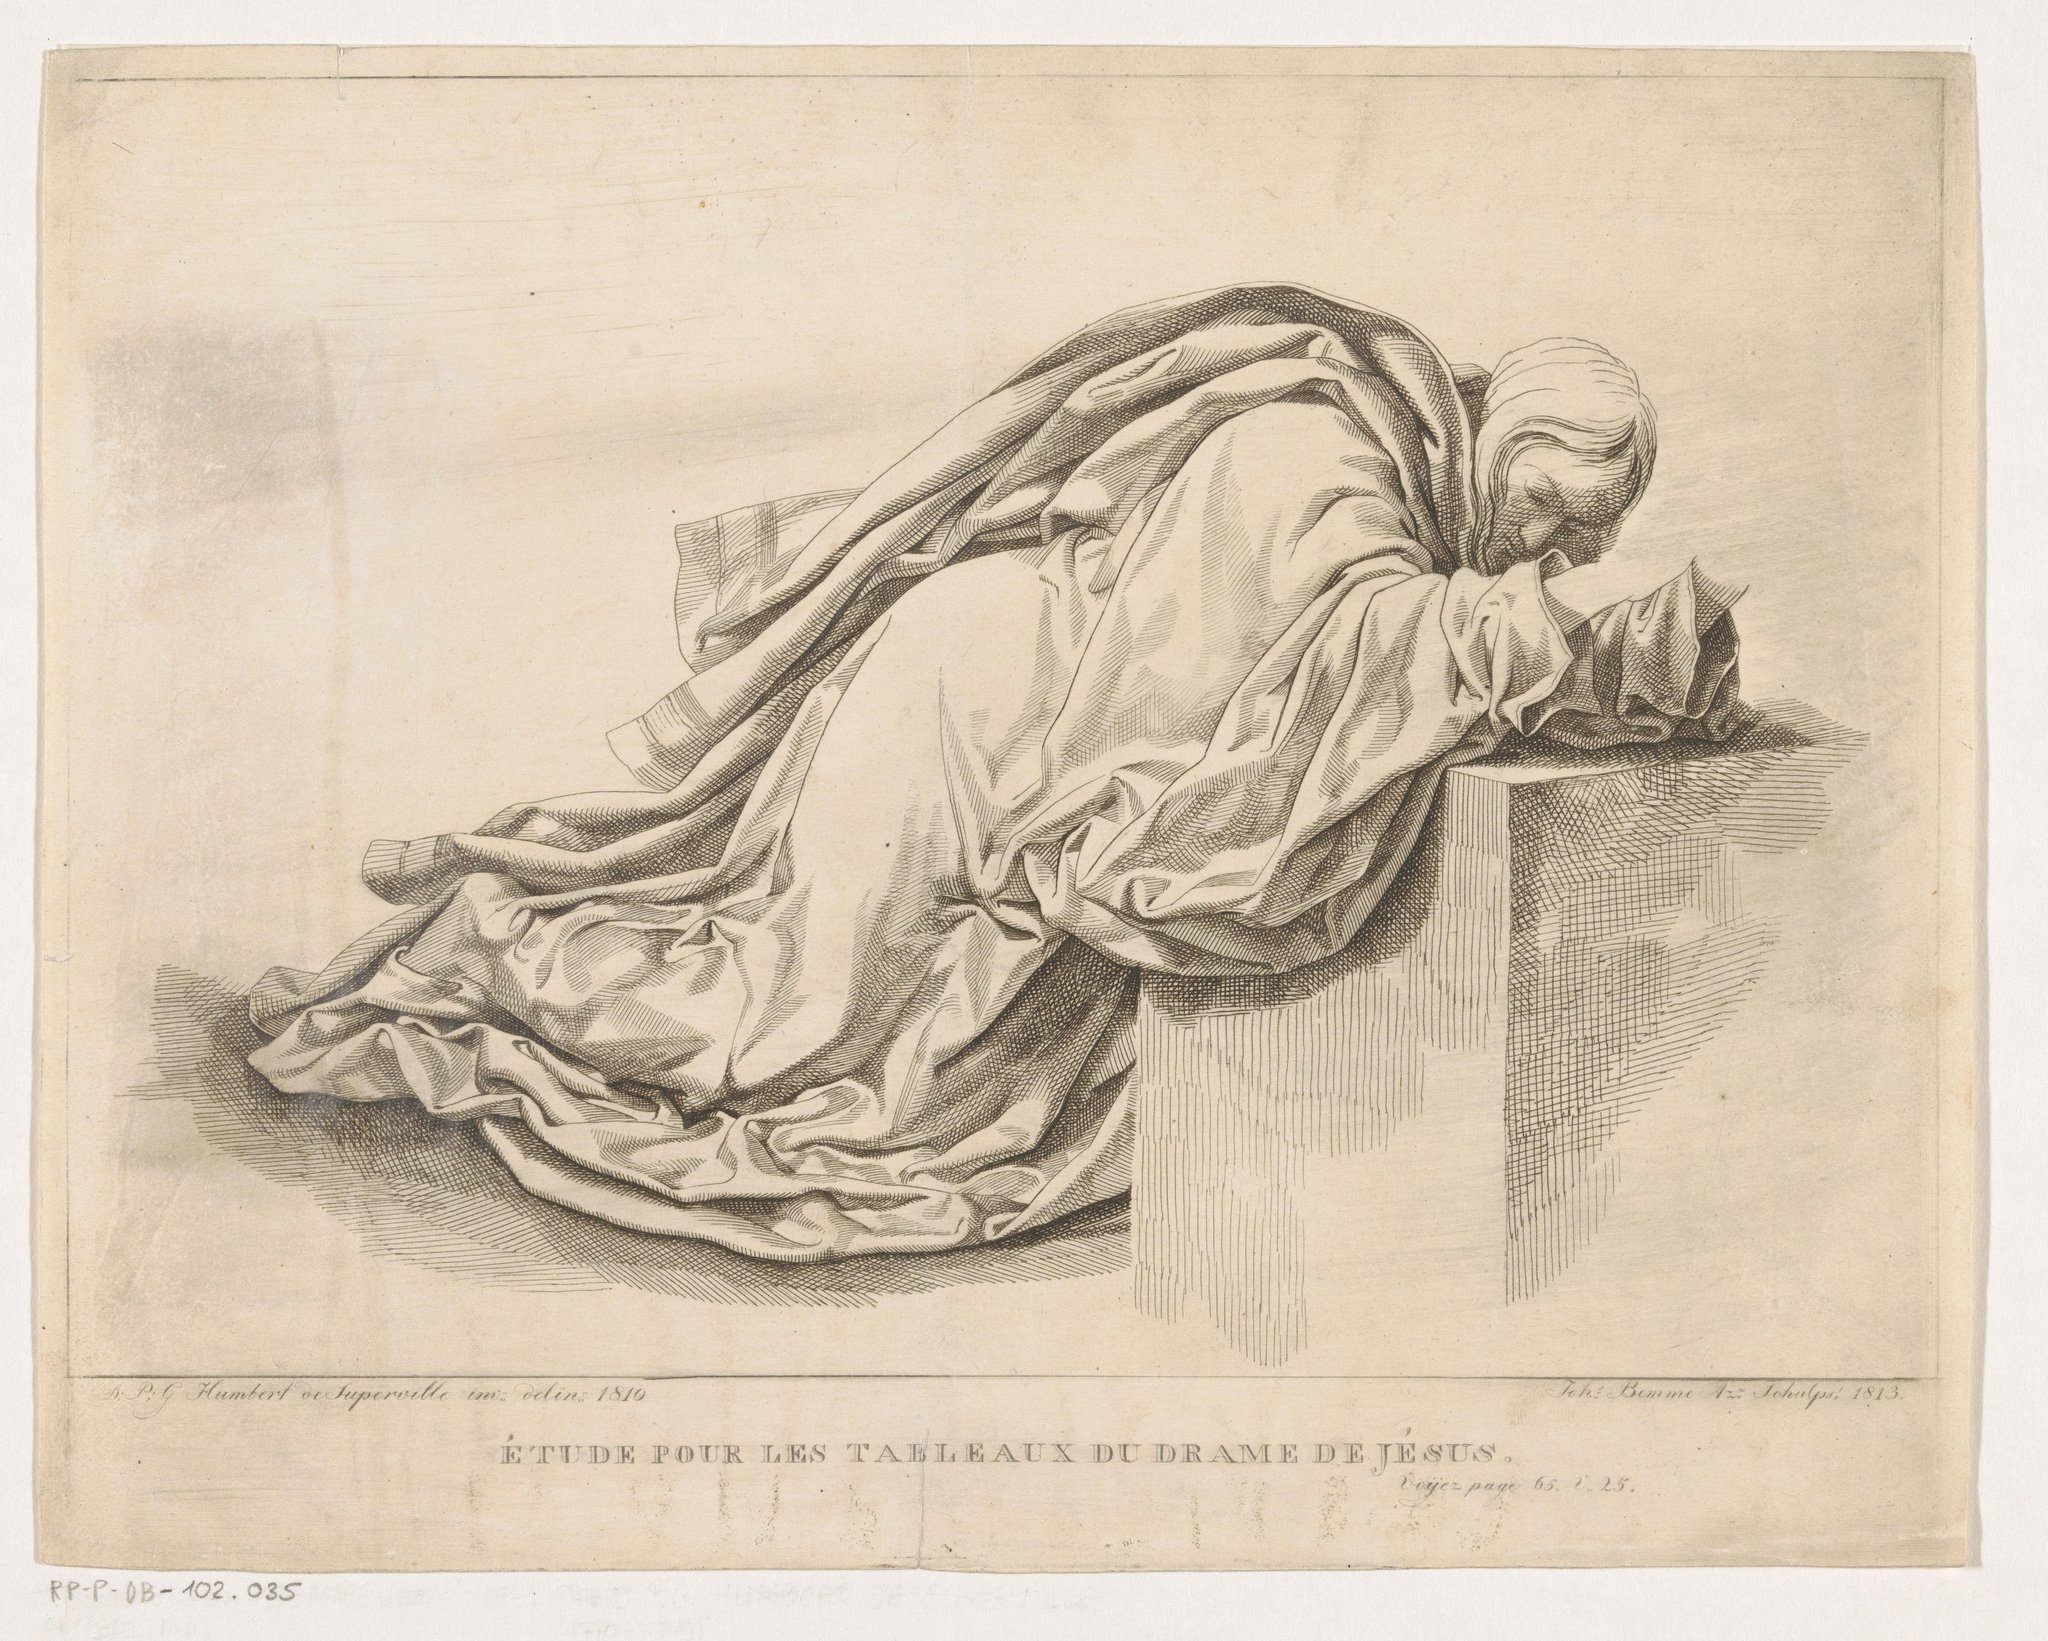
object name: print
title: Étude pour les tableaux du drame de Jésus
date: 1813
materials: paper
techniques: etching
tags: adult man (+ kneeling)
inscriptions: collector's mark: Lugt 698, collector's mark: Lugt 2228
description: Studie van een geknield liggende figuur, met wijd gewaad aan, op een stenen blok geleund. De handen zijn niet uitgewerkt.